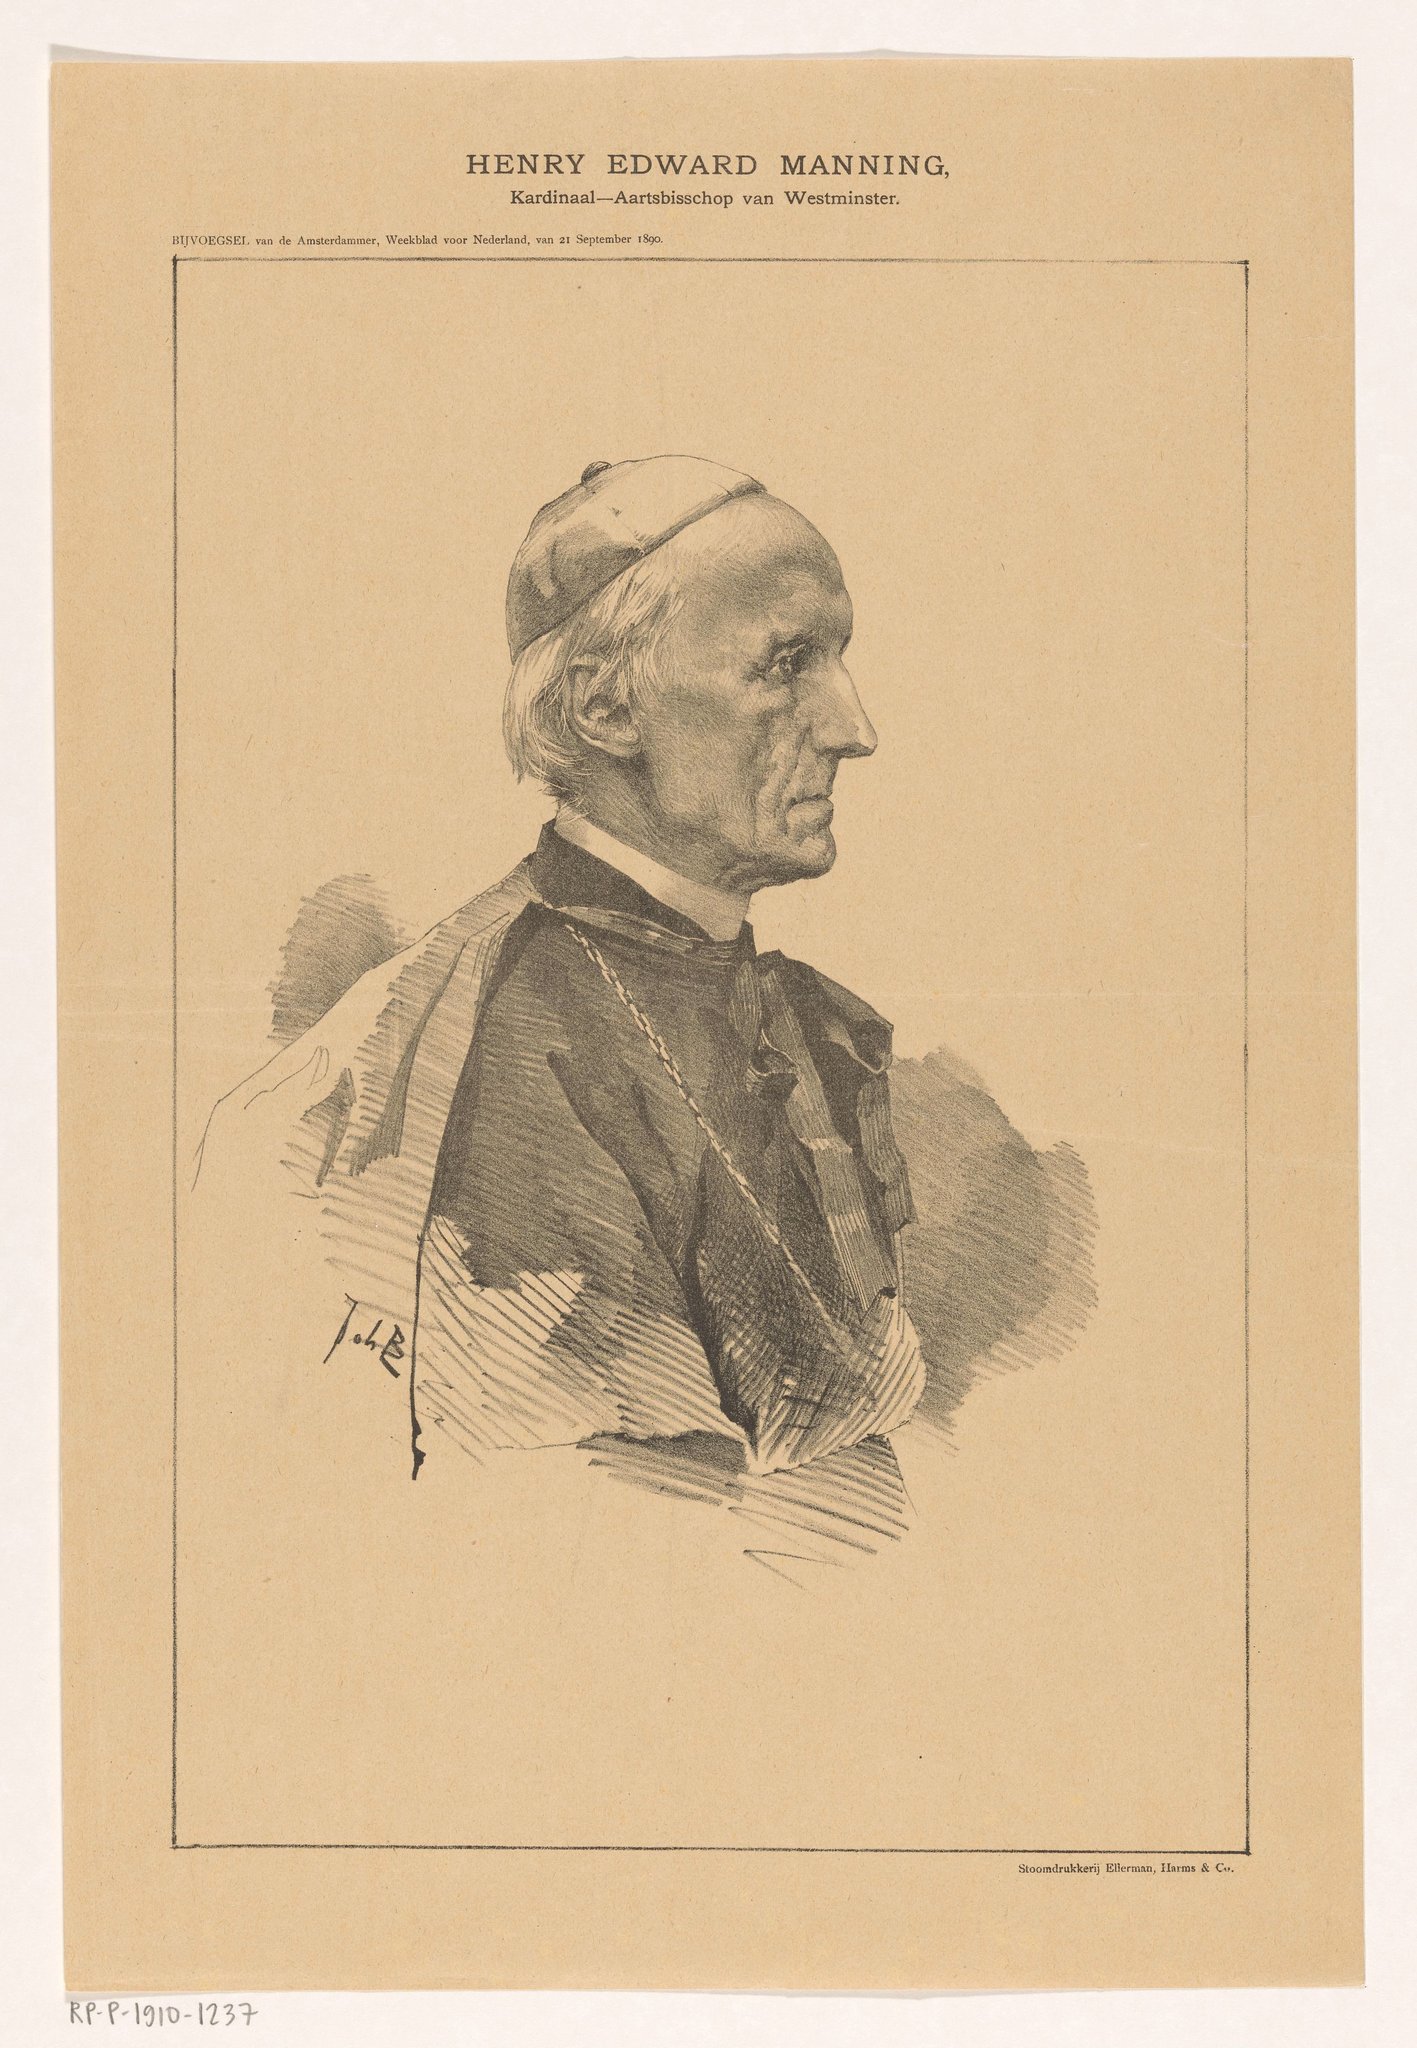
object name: print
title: Henry Edward Manning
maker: johan braakensiek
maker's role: draughtsman, print maker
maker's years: 1858-1940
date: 1890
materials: paper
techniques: lithograph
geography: amsterdam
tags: cardinal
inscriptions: collector's mark: Lugt 2228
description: Verschenen in het bijvoegsel van 'De Amsterdammer, Weekblad voor Nederland' van 21 september 1890.